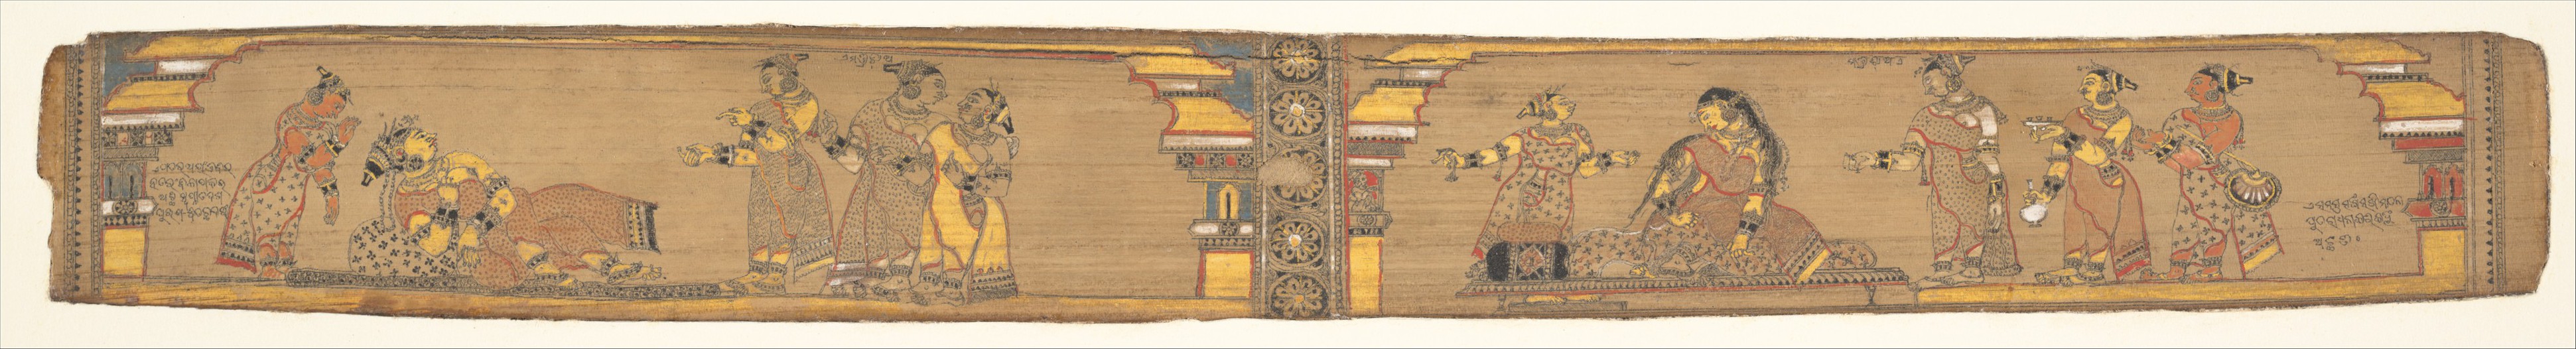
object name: folio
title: Page from a Dispersed Romance of Chandrabhanu and Lavanyavati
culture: indian, orissan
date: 1501-1700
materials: ink, leaf, watercolor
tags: women